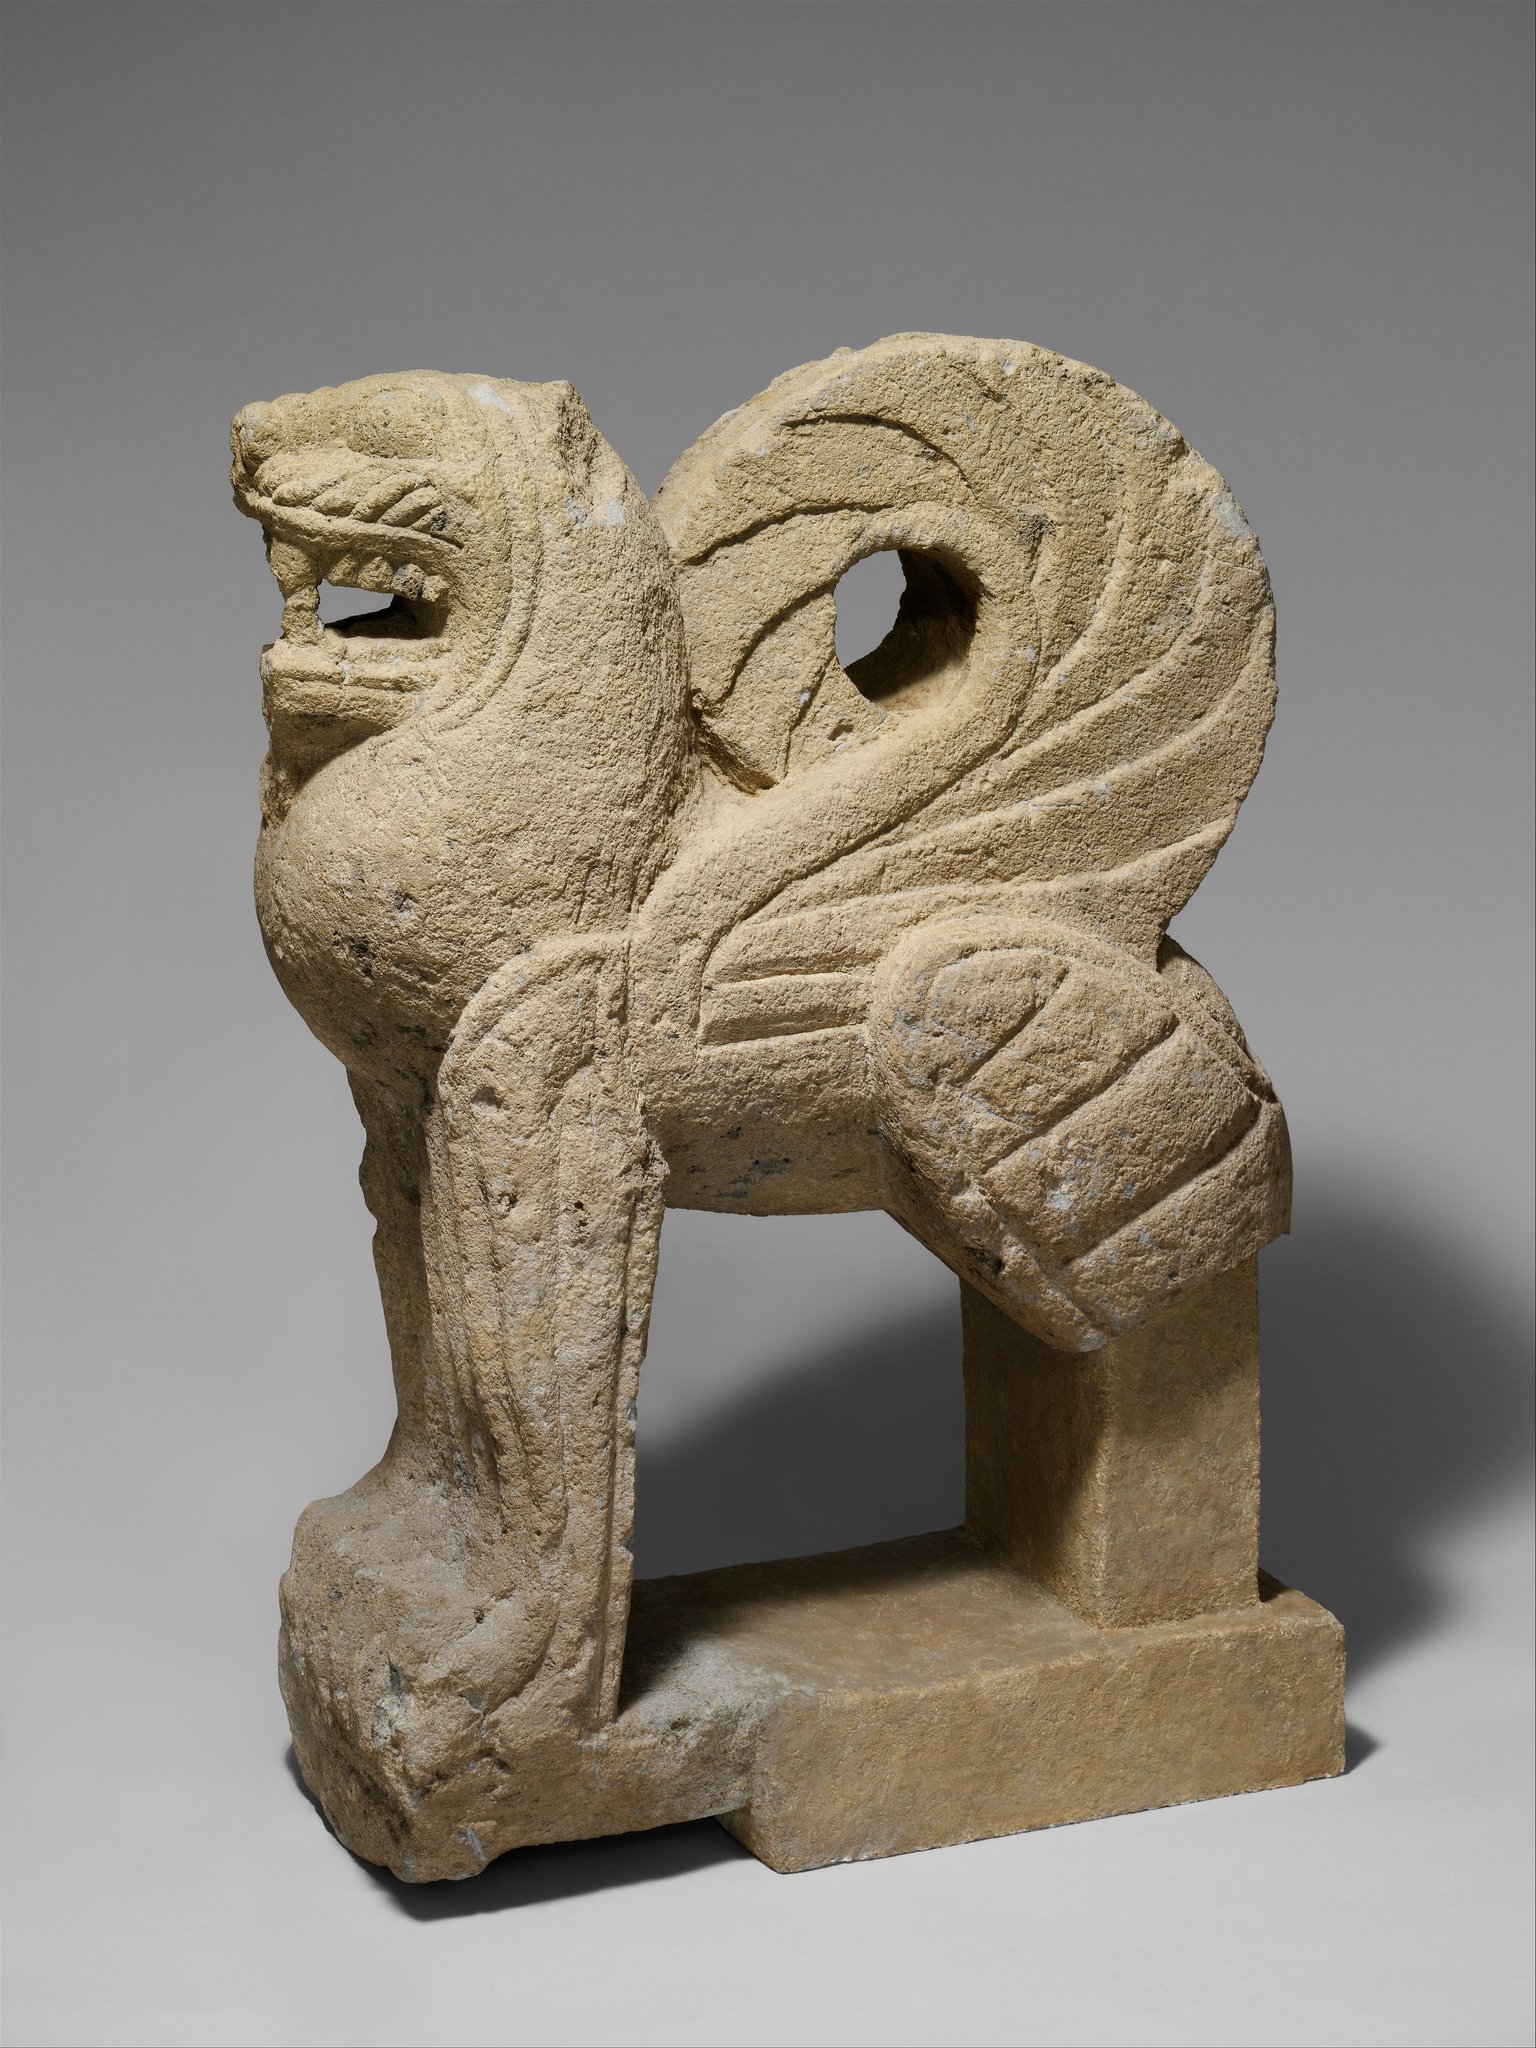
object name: statue of a winged lion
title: Nenfro statue of a winged lion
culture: etruscan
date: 550 BCE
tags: lions